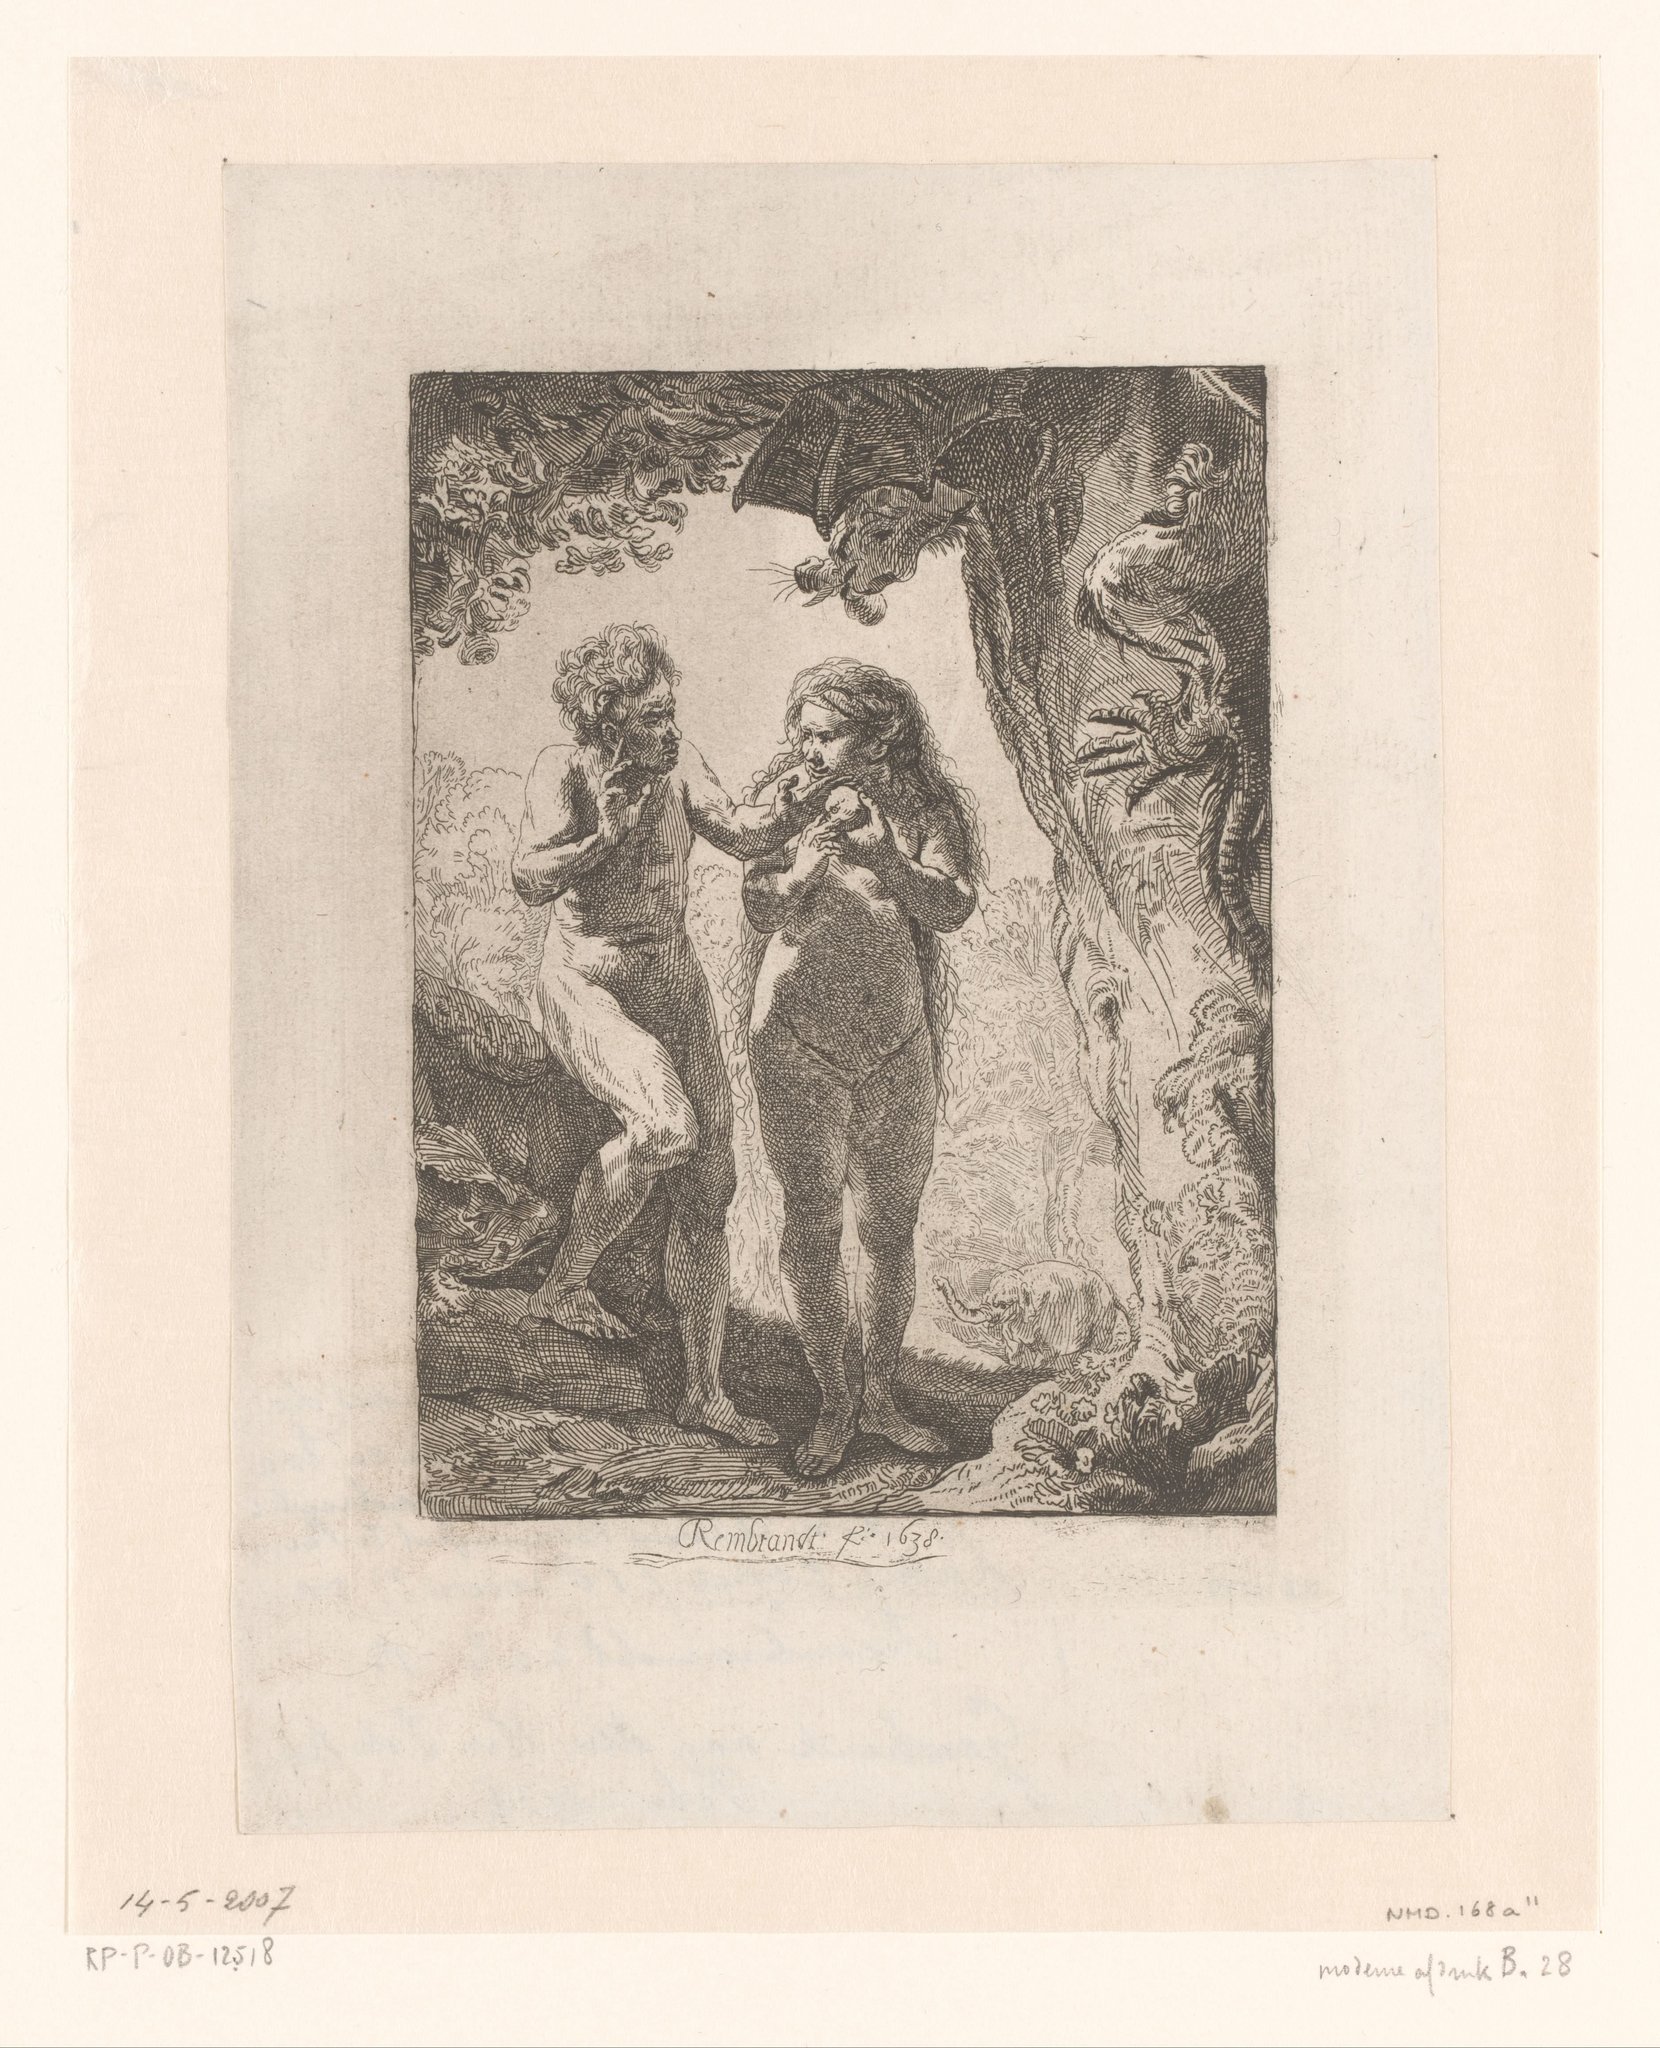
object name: print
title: Adam and Eve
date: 1733-1797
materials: paper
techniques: etching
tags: temptation and fall (genesis 3:1-7)